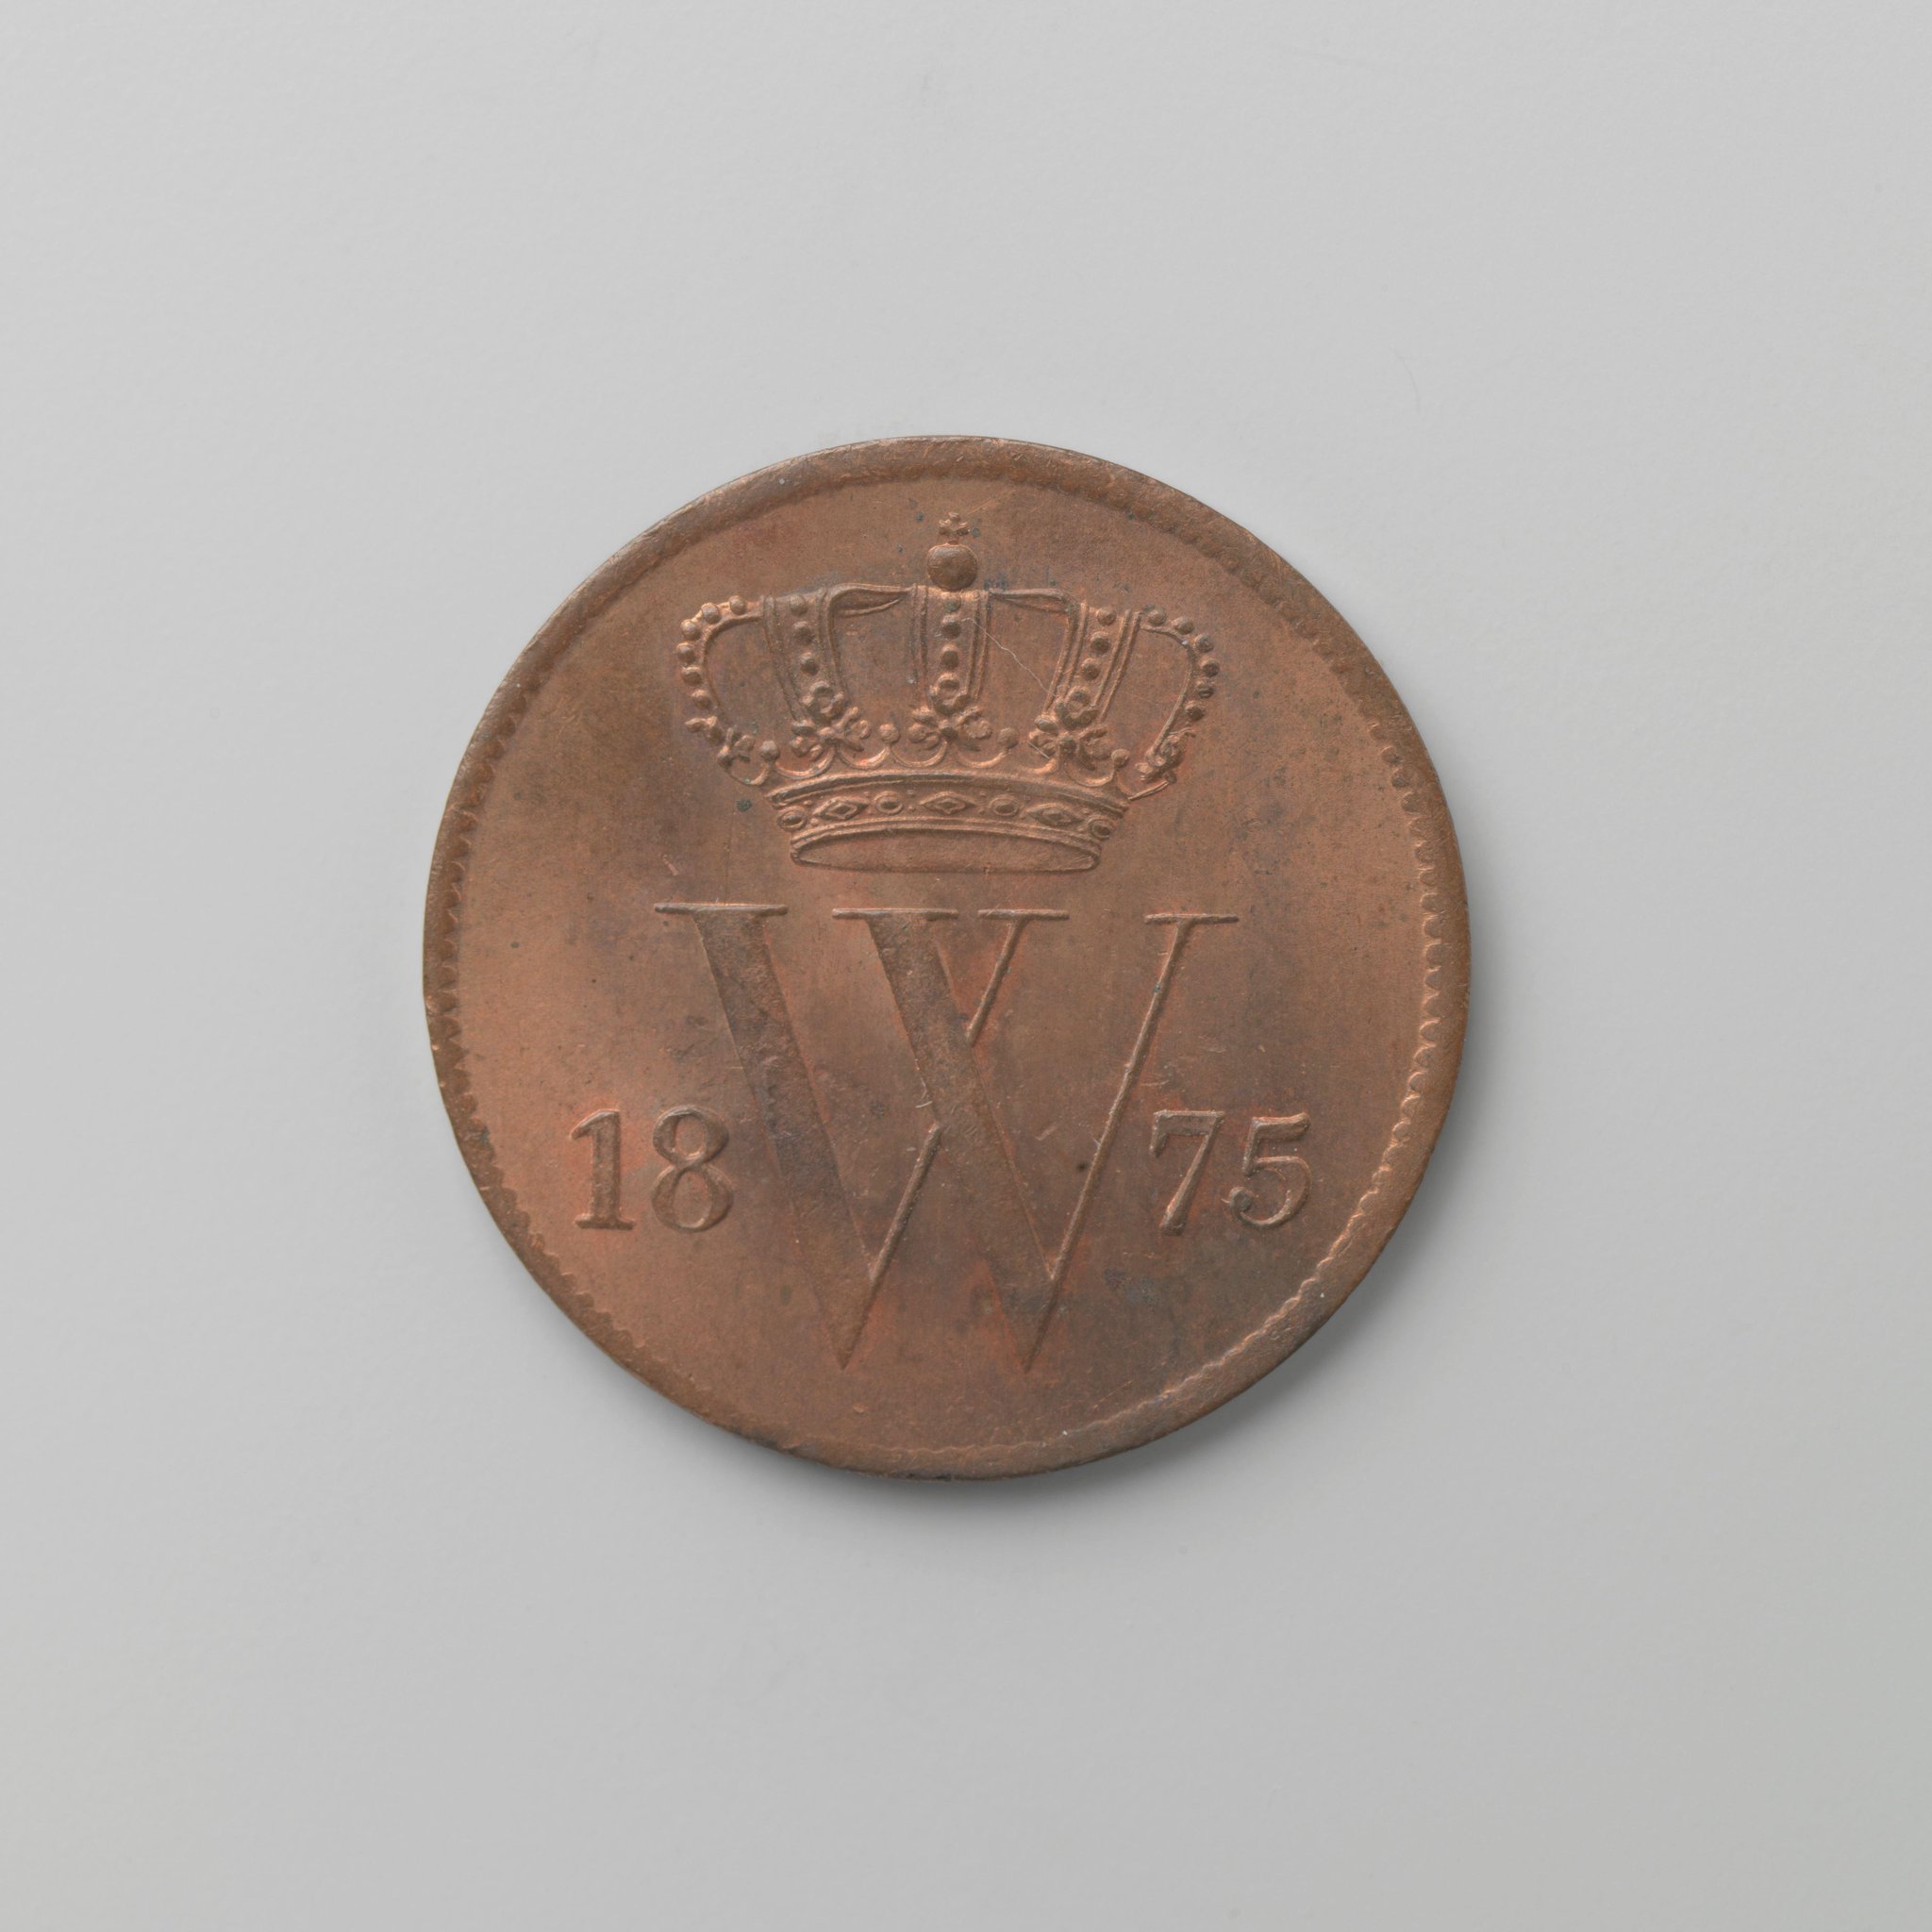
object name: coin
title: Nederlandse cent, 1875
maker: willem iii (koning der nederlanden)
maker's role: koning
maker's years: 1817-1890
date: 1875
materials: copper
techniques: striking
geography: utrecht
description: Koperen munt. Voorzijde: tussen jaartal gekroonde rechte letter W. Keerzijde: tussen waarde-aanduiding 1 C. gekroond rijkswapenschild. Gladde rand.